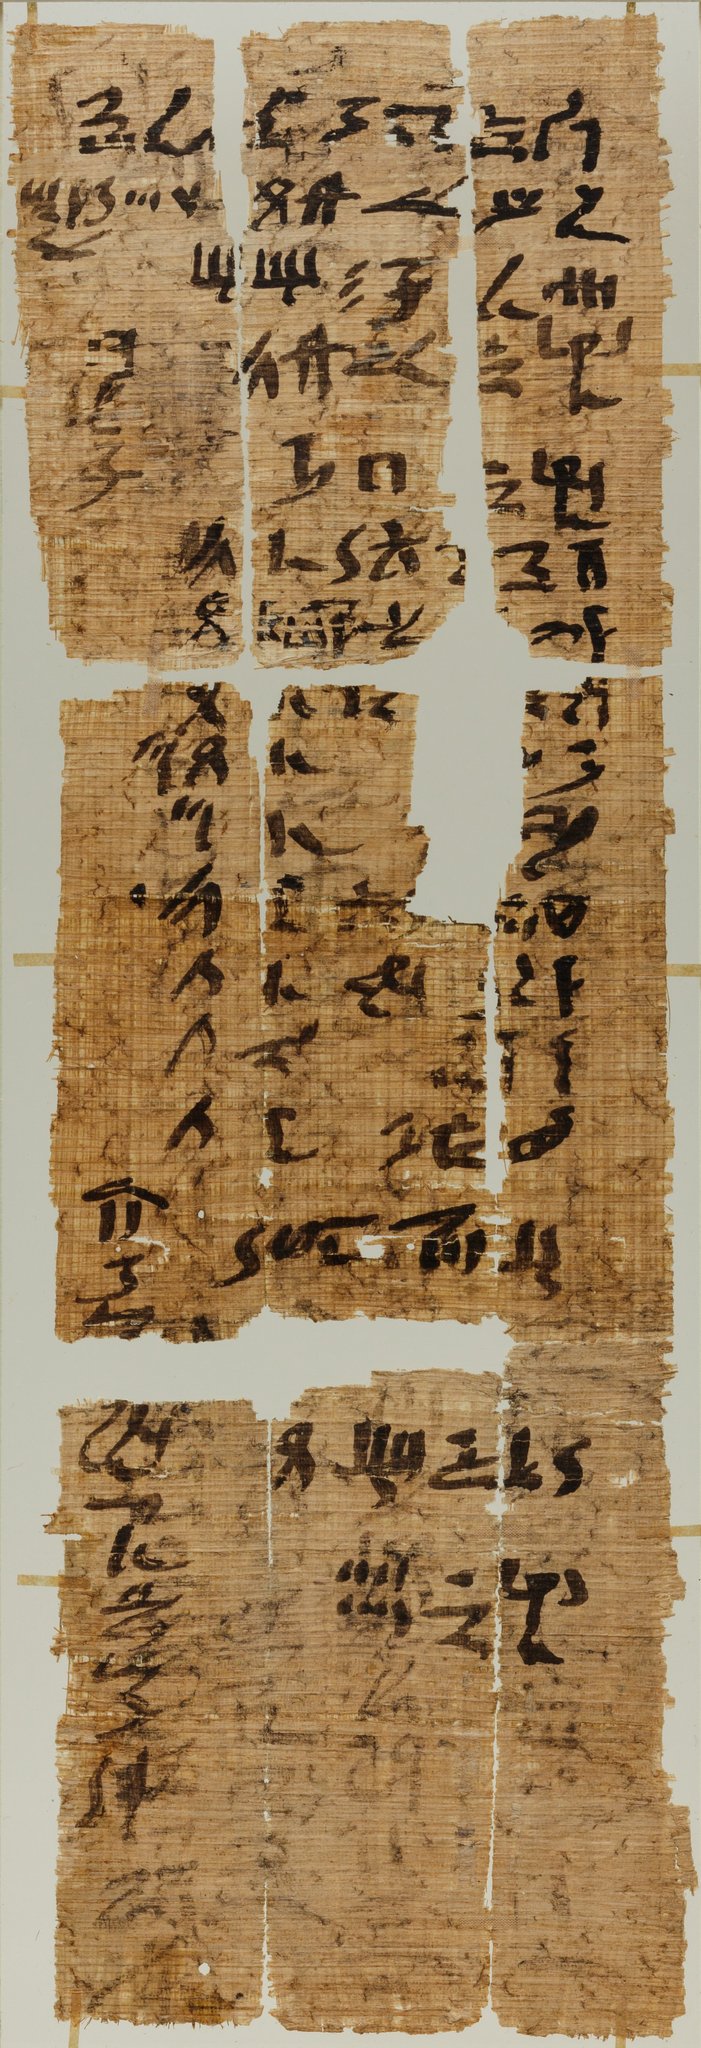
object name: papyrus, heqanakht, servant, copper, grain, flax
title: Heqanakht's account, written over an effaced letter regarding two female servants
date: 1956-1953 BCE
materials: ink, papyrus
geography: egypt